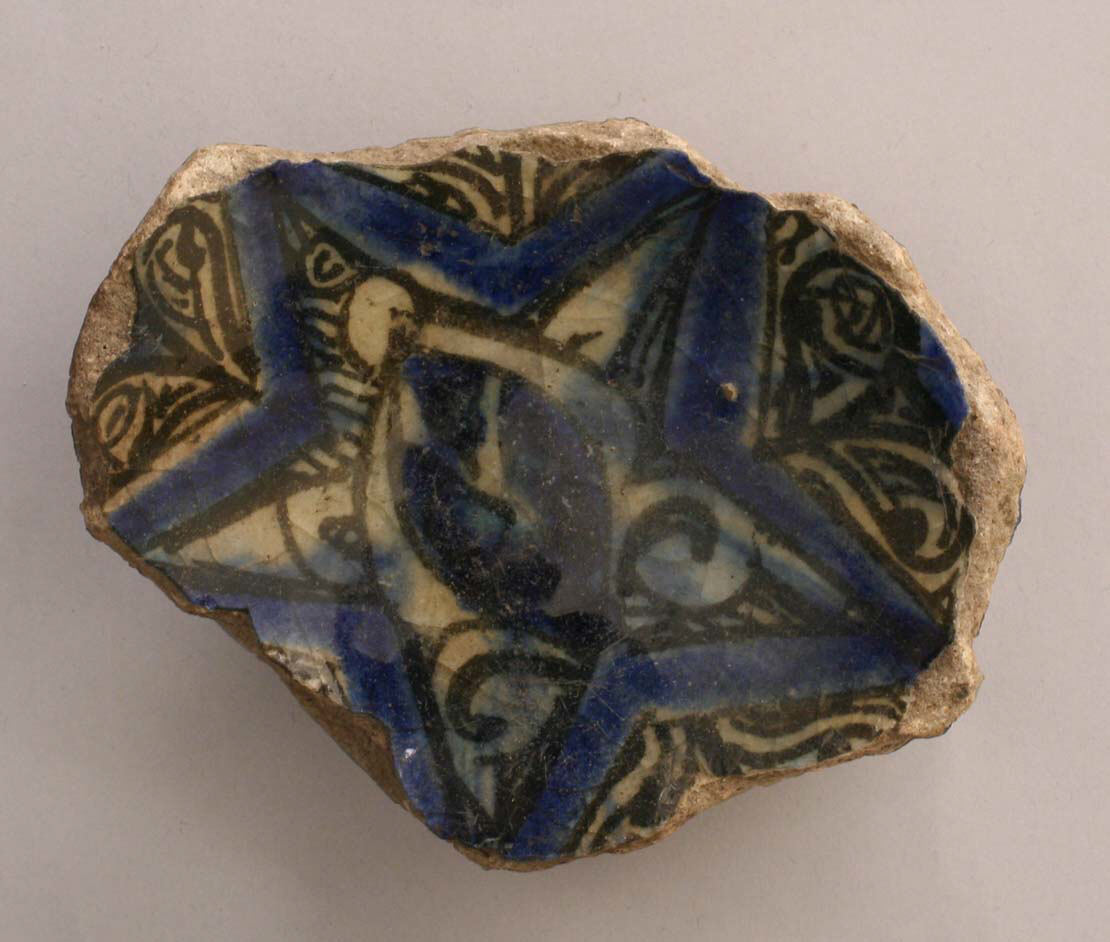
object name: fragment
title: Ceramic Fragment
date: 1301-1400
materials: glaze, stonepaste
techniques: painting, polychrome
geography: syria